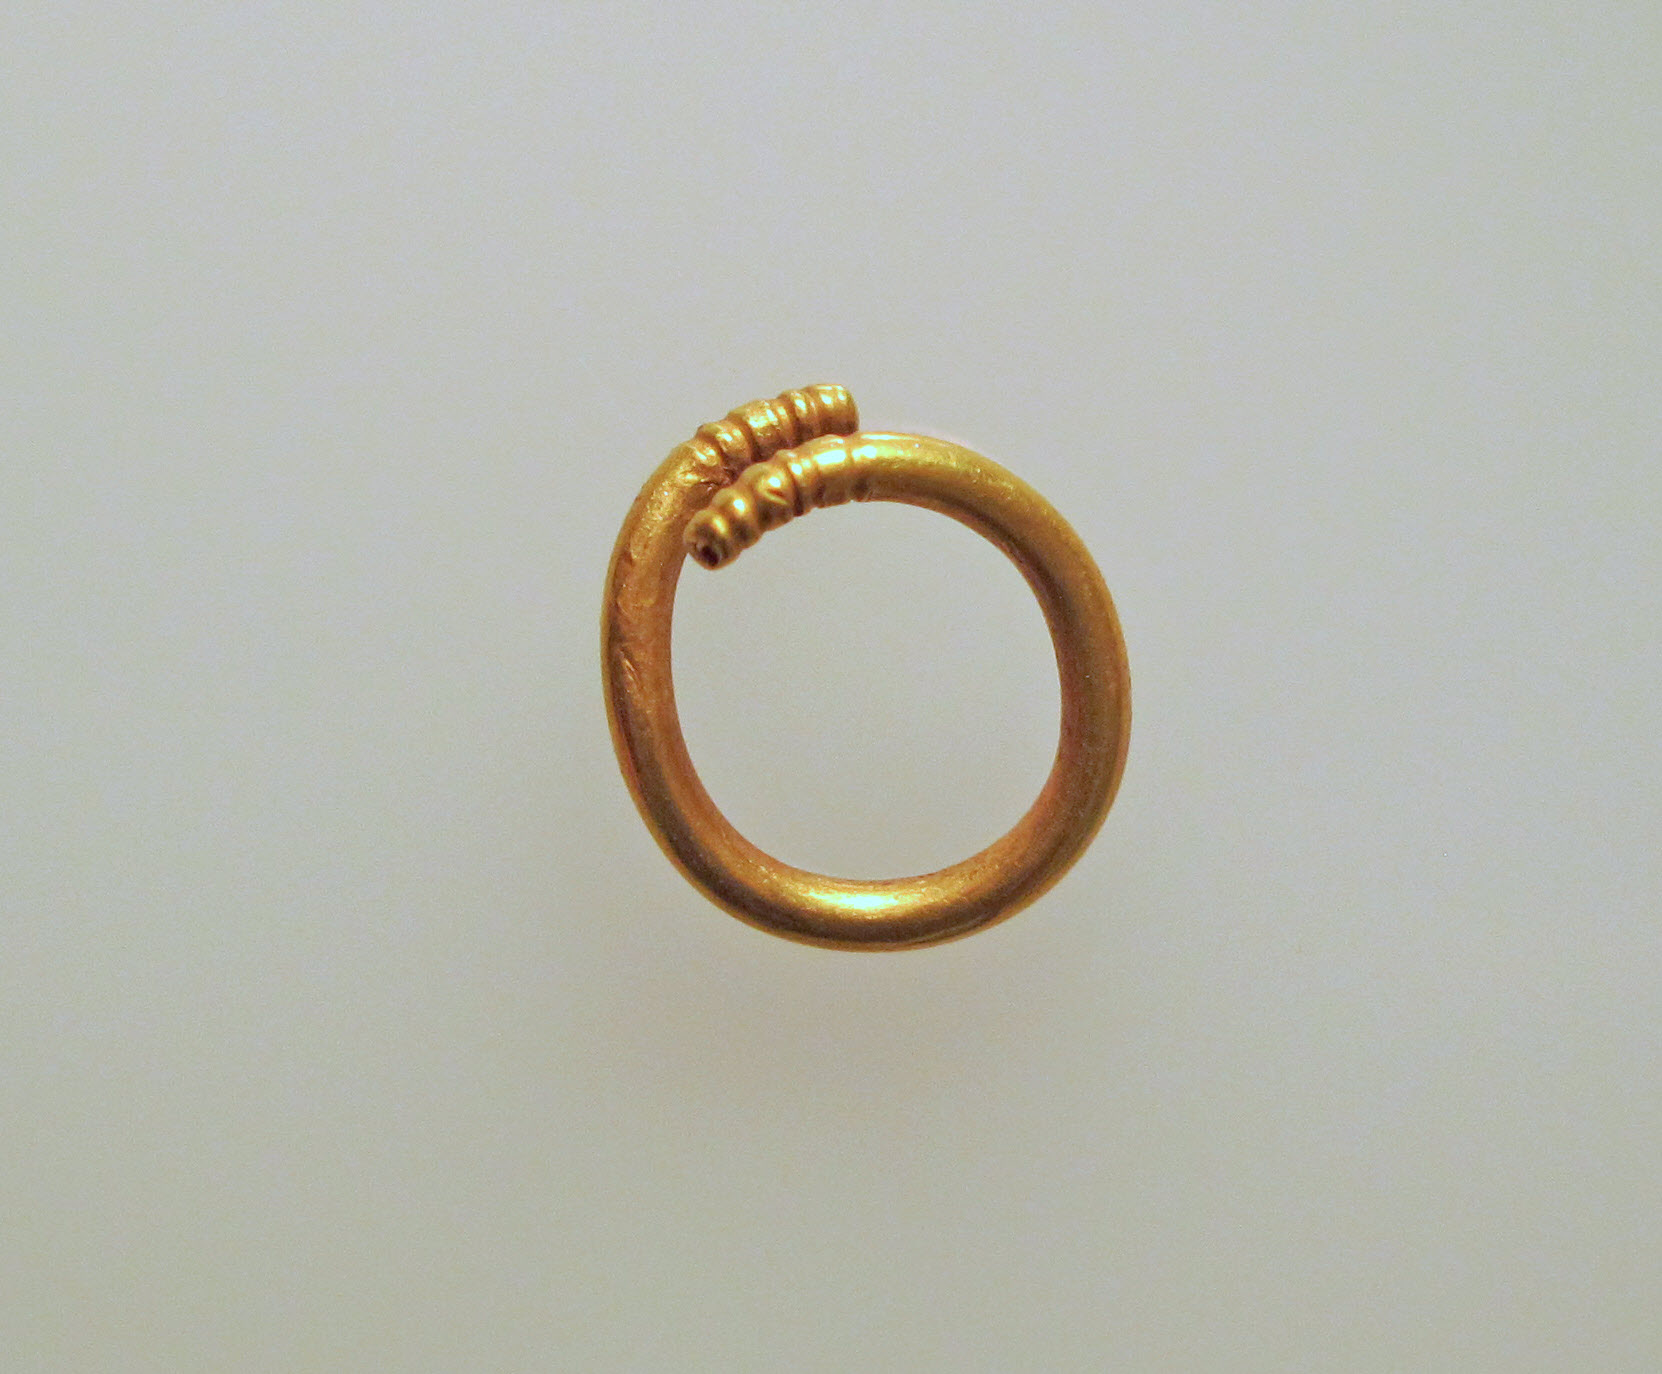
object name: spiral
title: Spirals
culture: cypriot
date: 3900 BCE-100 CE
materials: gold